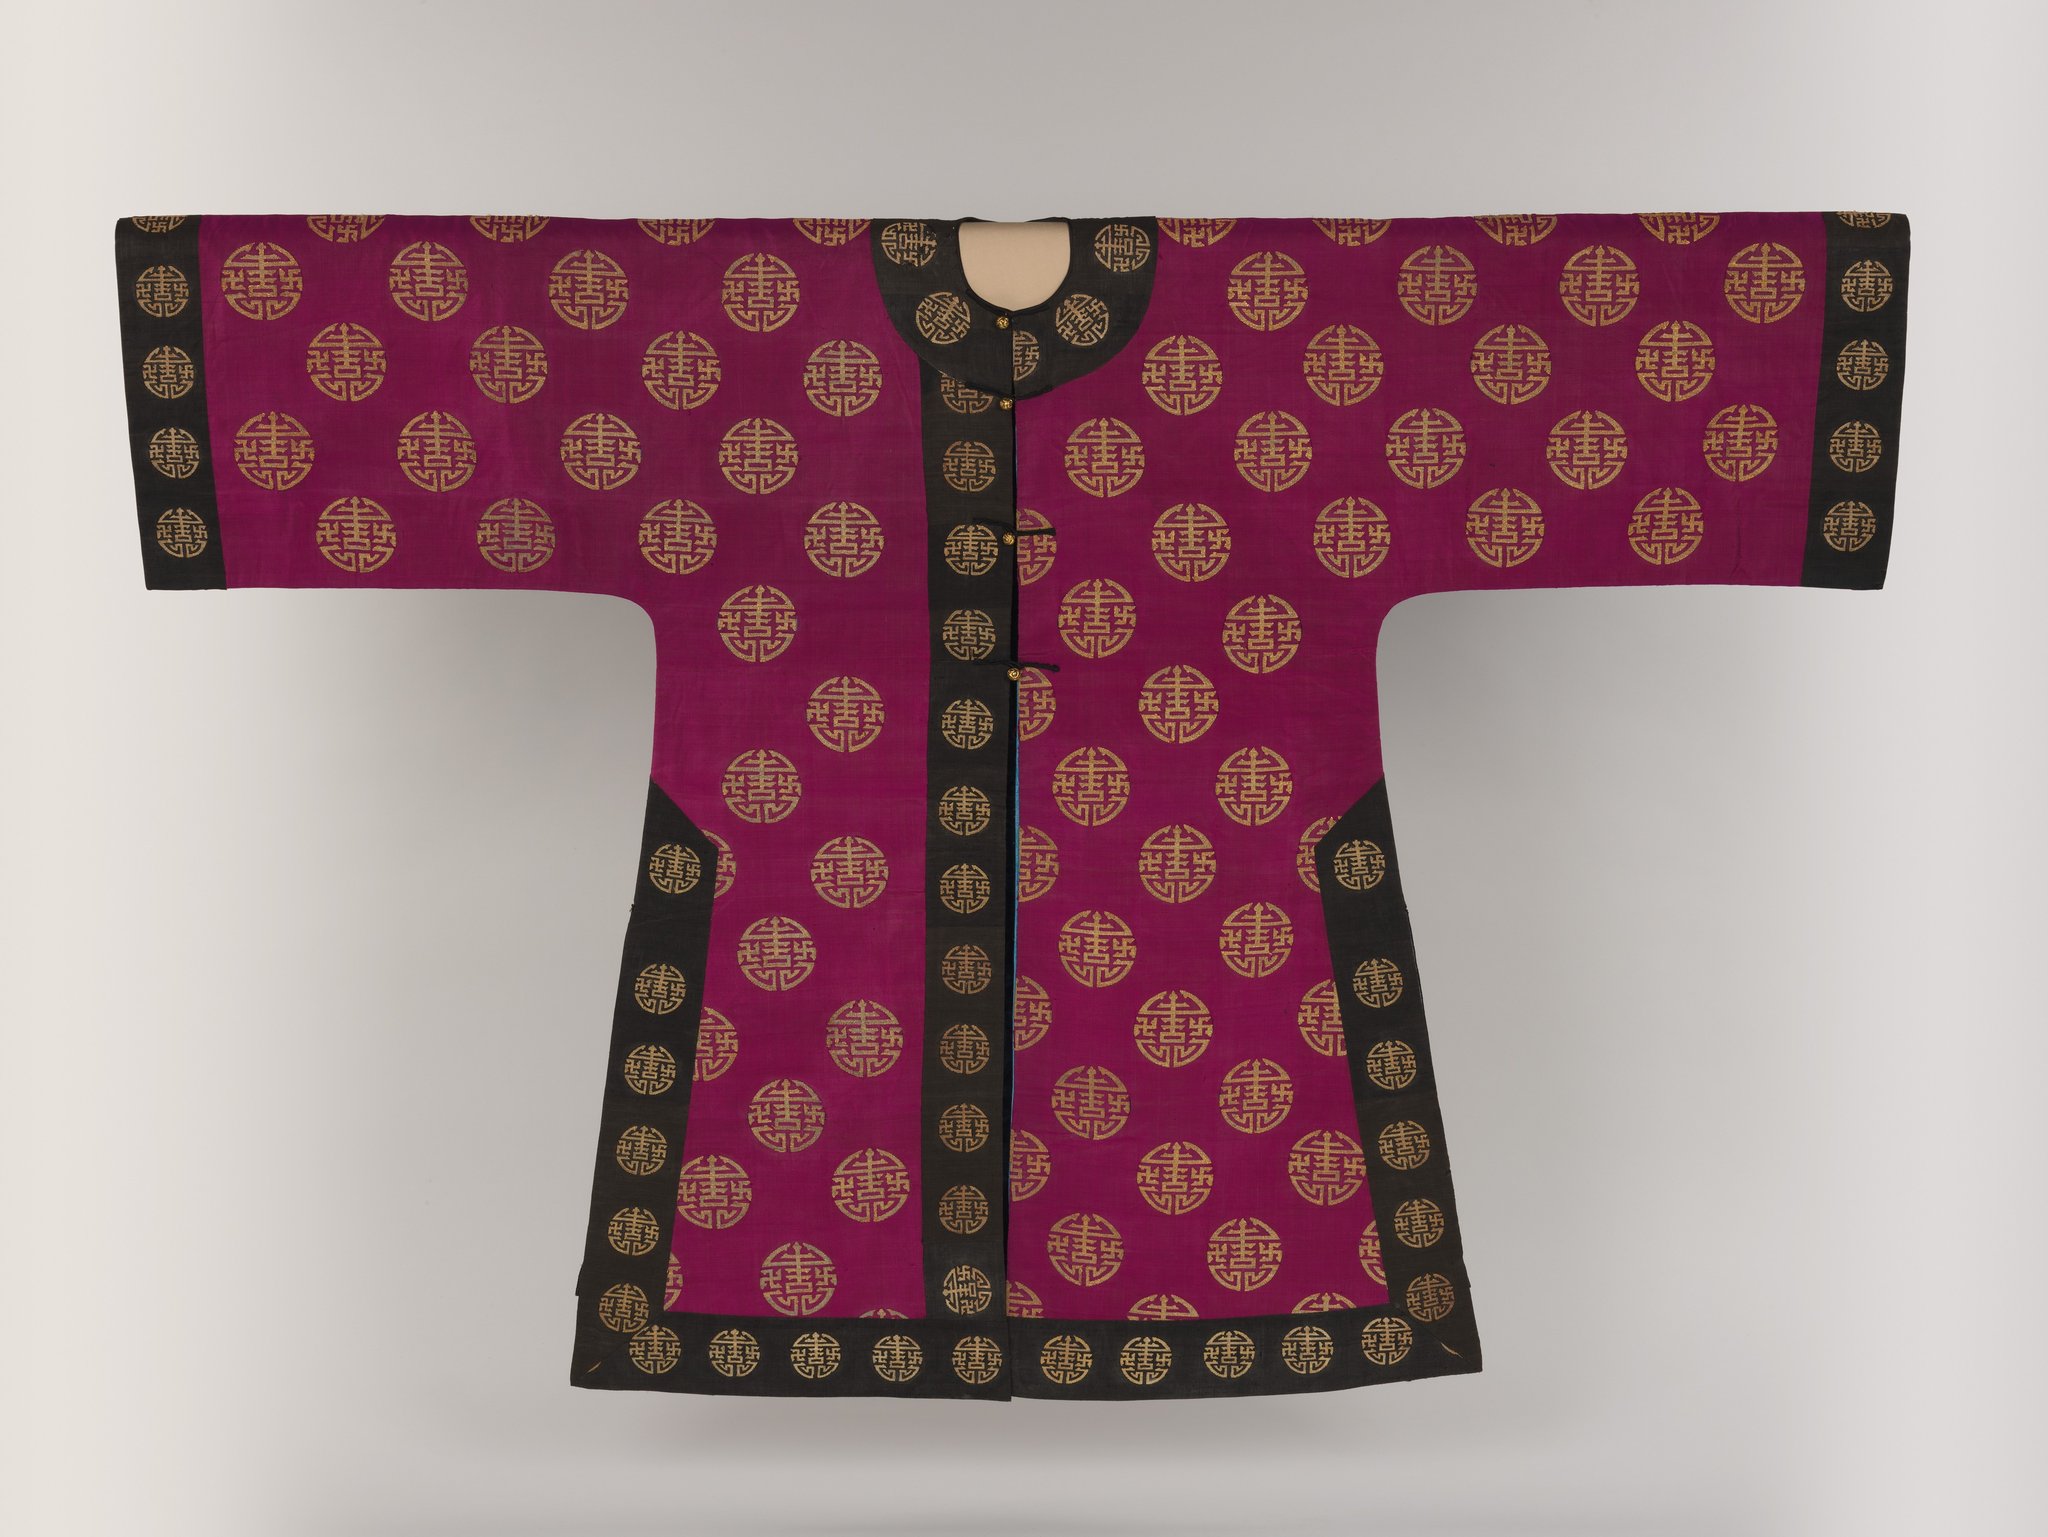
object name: woman's birthday coat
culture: chinese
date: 1867-1900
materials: metal thread, silk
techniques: tapestry